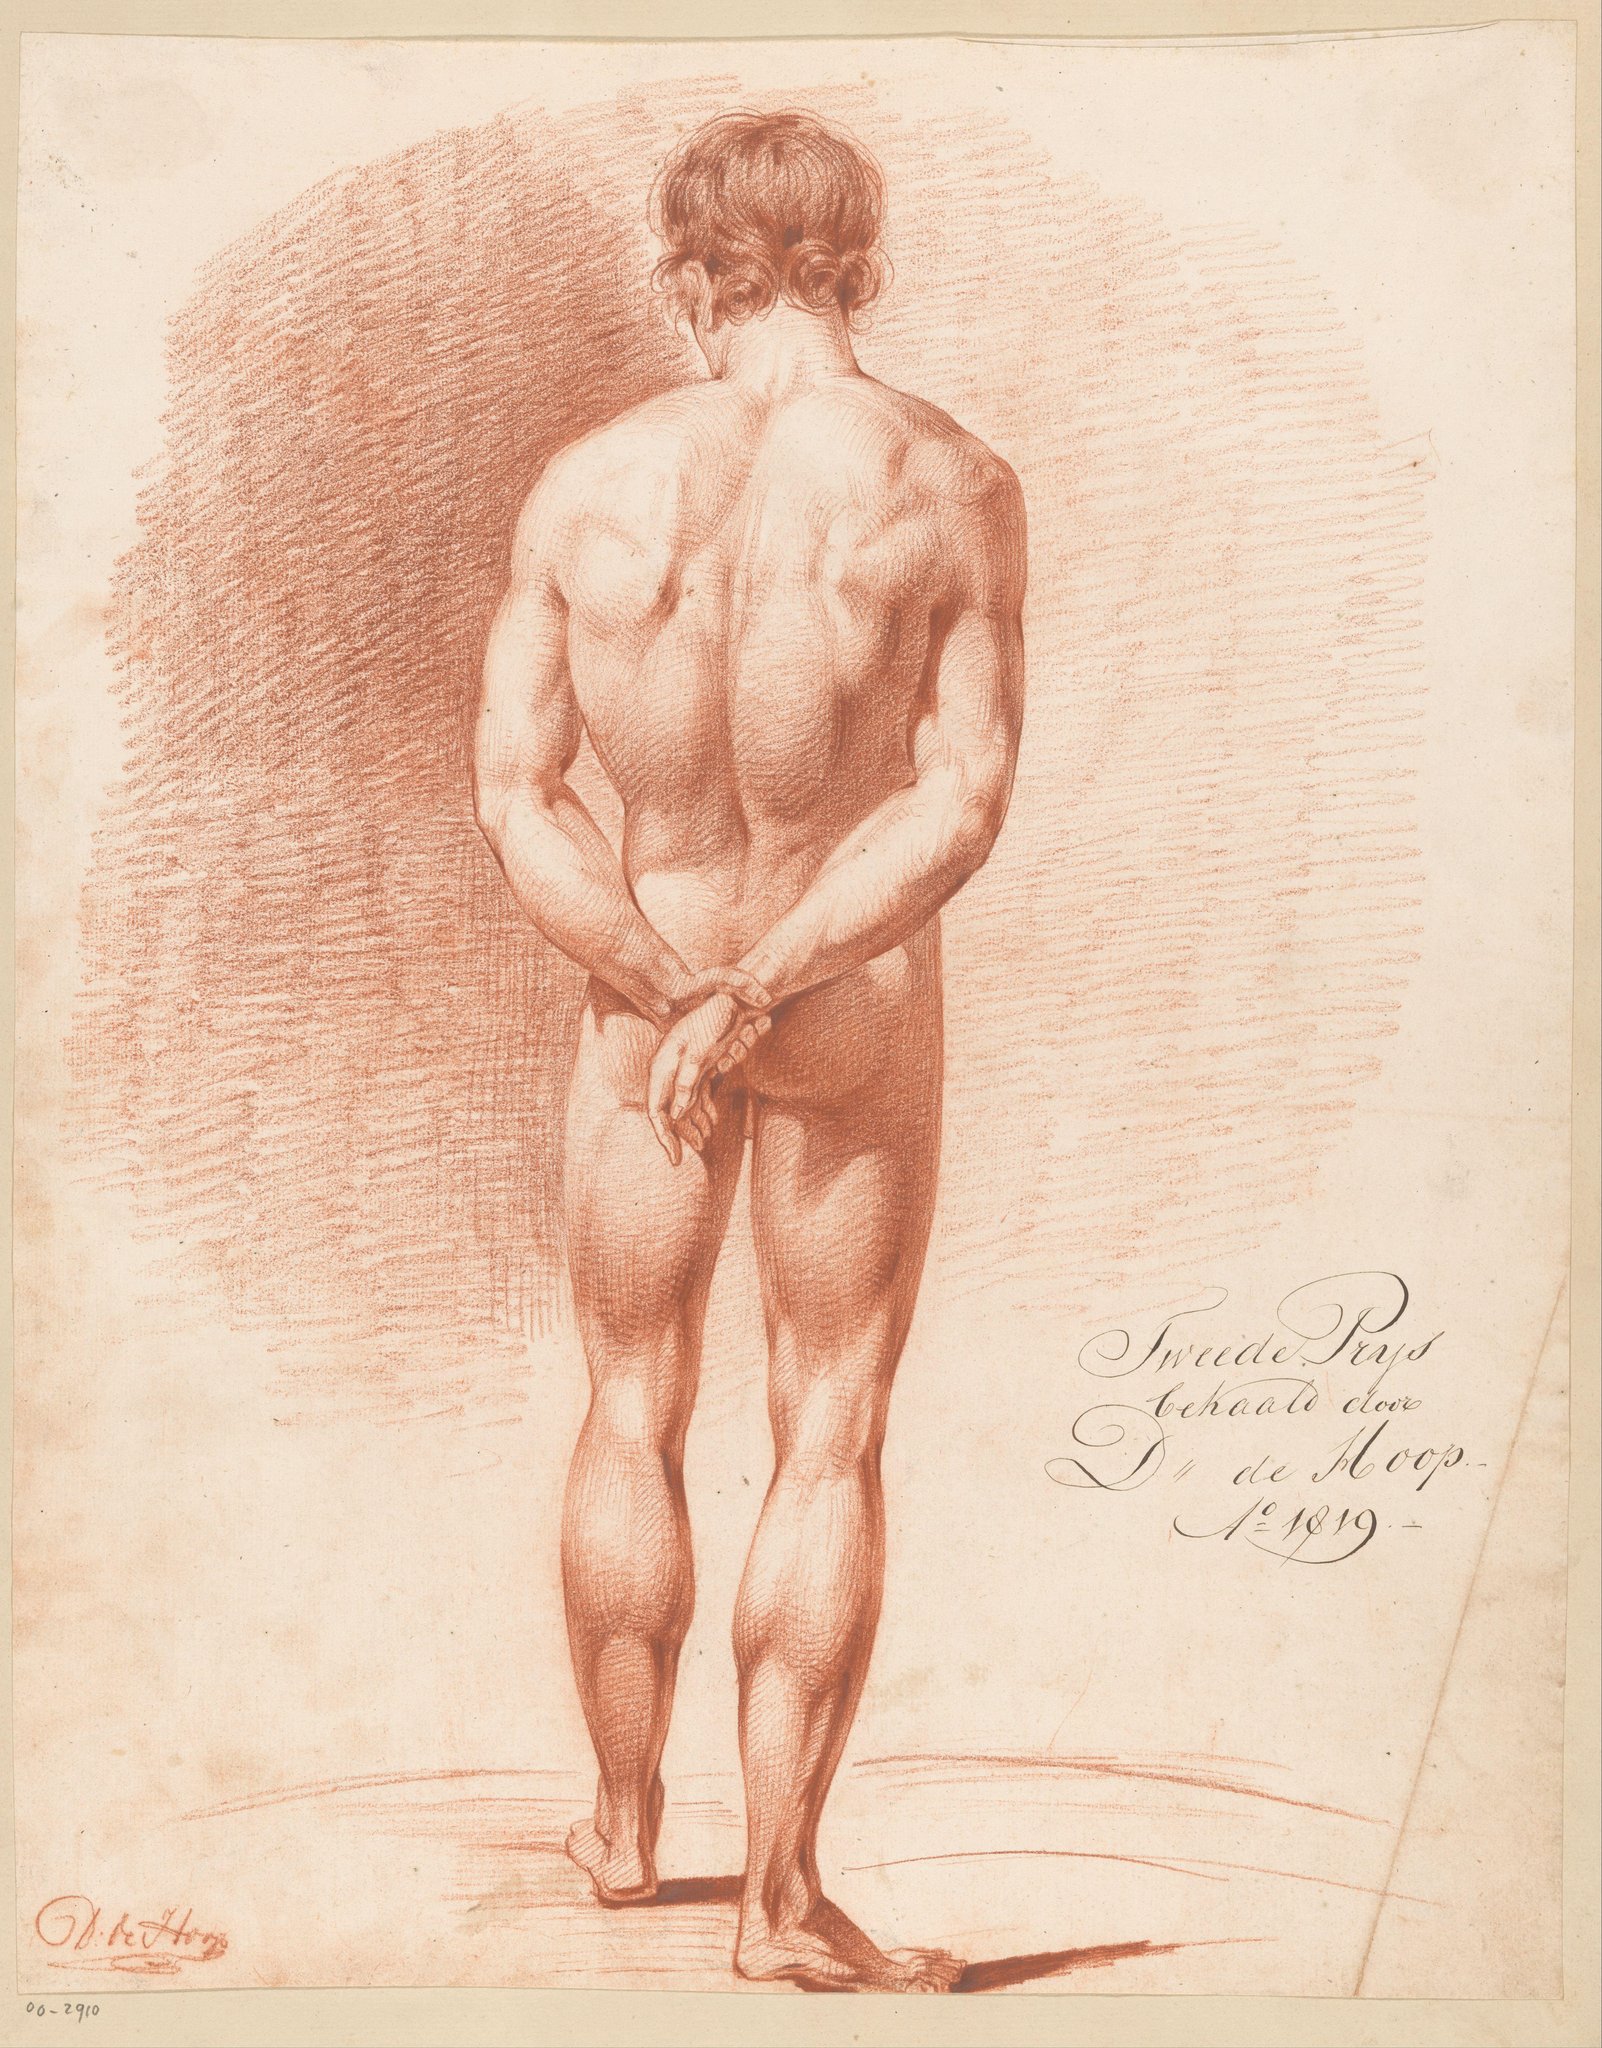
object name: drawing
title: Staand mannelijk naakt, op de rug gezien (2e prijs 1819)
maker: douwe de hoop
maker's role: draughtsman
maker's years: 1800-1830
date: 1819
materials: chalk, paper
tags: standing figure (+ nude human being)